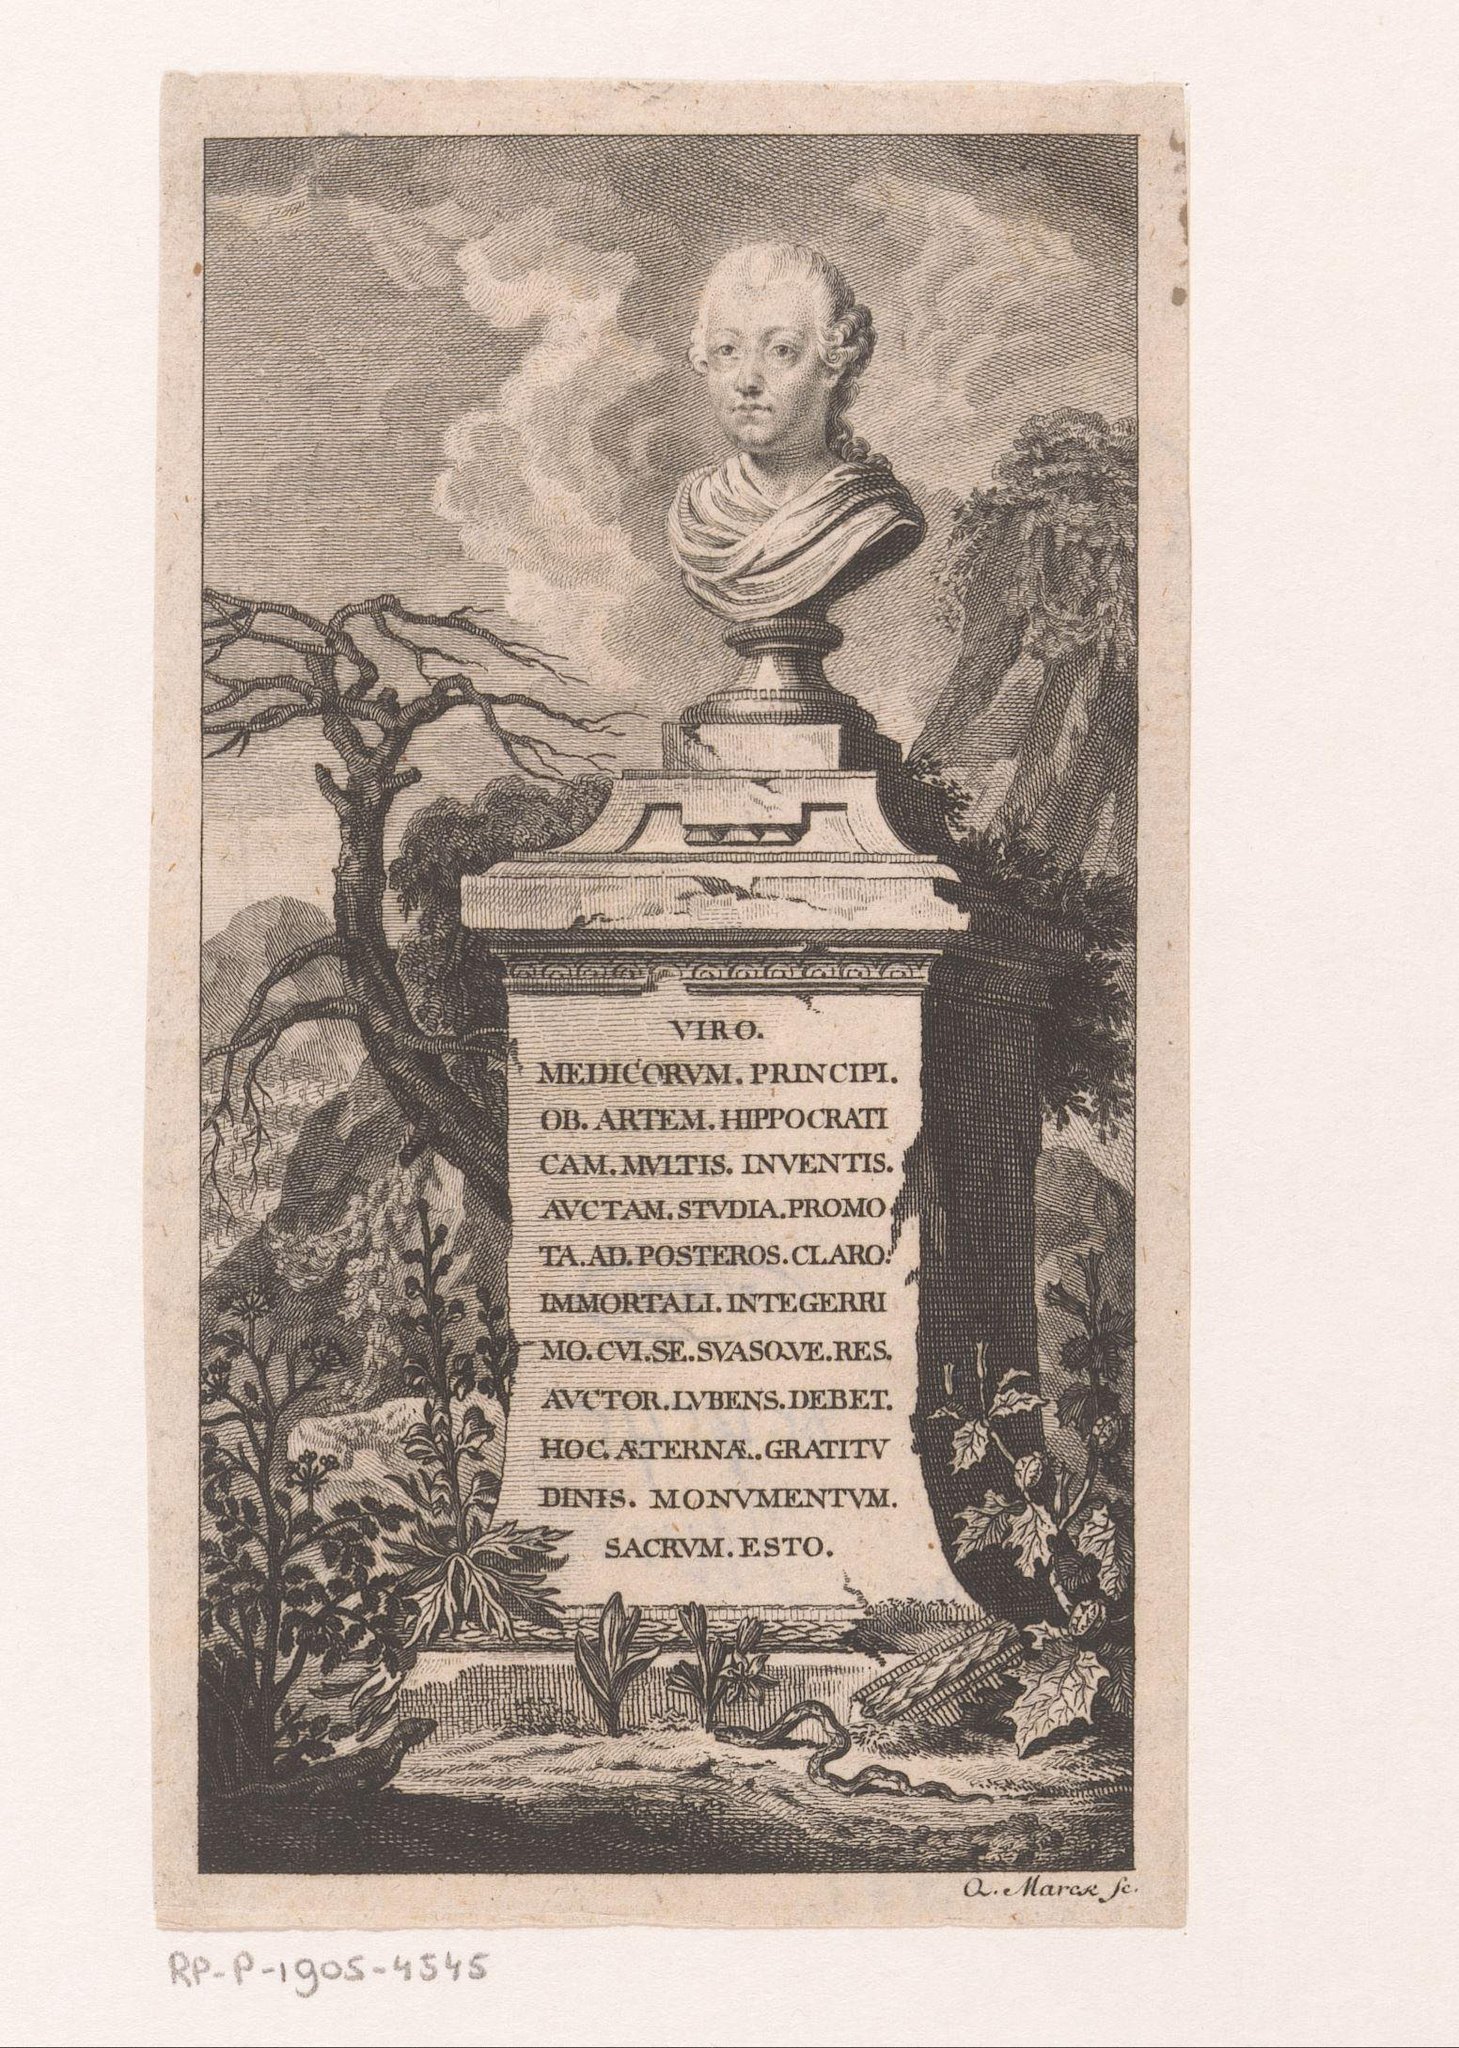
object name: print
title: Monument met een buste, mogelijk Gerard van Swieten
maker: quirin mark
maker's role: print maker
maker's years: 1753-1811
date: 1763-1811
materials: paper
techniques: engraving, etching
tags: leiden, vienna, historical persons, monument, statue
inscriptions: collector's mark: Lugt 2228